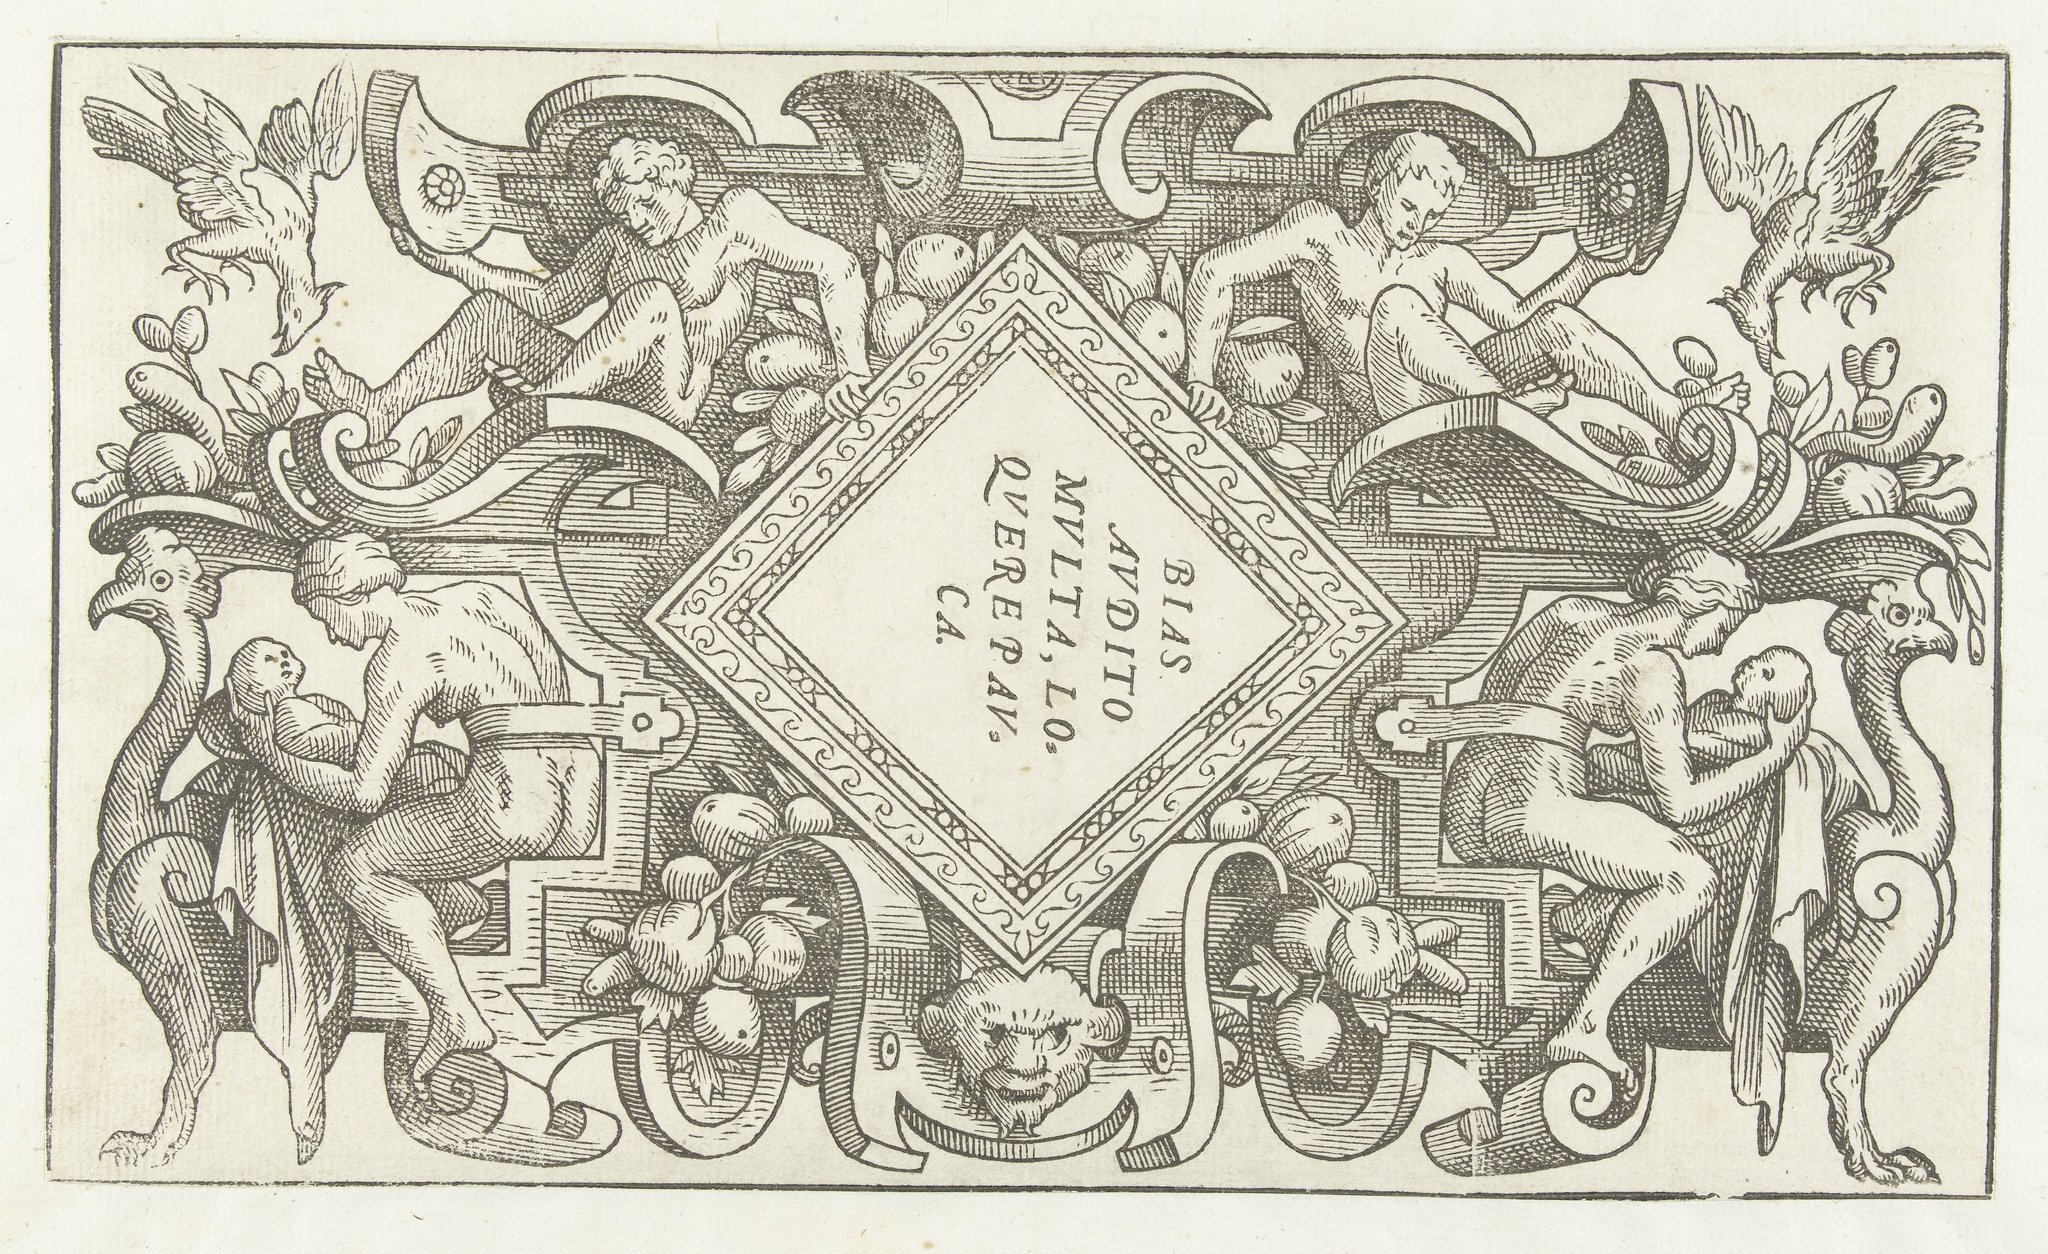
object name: ornament print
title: Ruitvormige cartouche met een citaat van Bias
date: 1556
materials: paper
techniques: woodcut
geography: netherlands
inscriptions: number: ‘107’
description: De cartouche hangt dwars in de omlijsting van rolwerk. In het rolwerk zitten bovenaan twee figuren. In de linker en rechter onderhoek zit een vrouw met een baby. Blad hoort bij 15 bladen met titelblad afkomstig uit een serie van 24 bladen. Houtsneden.